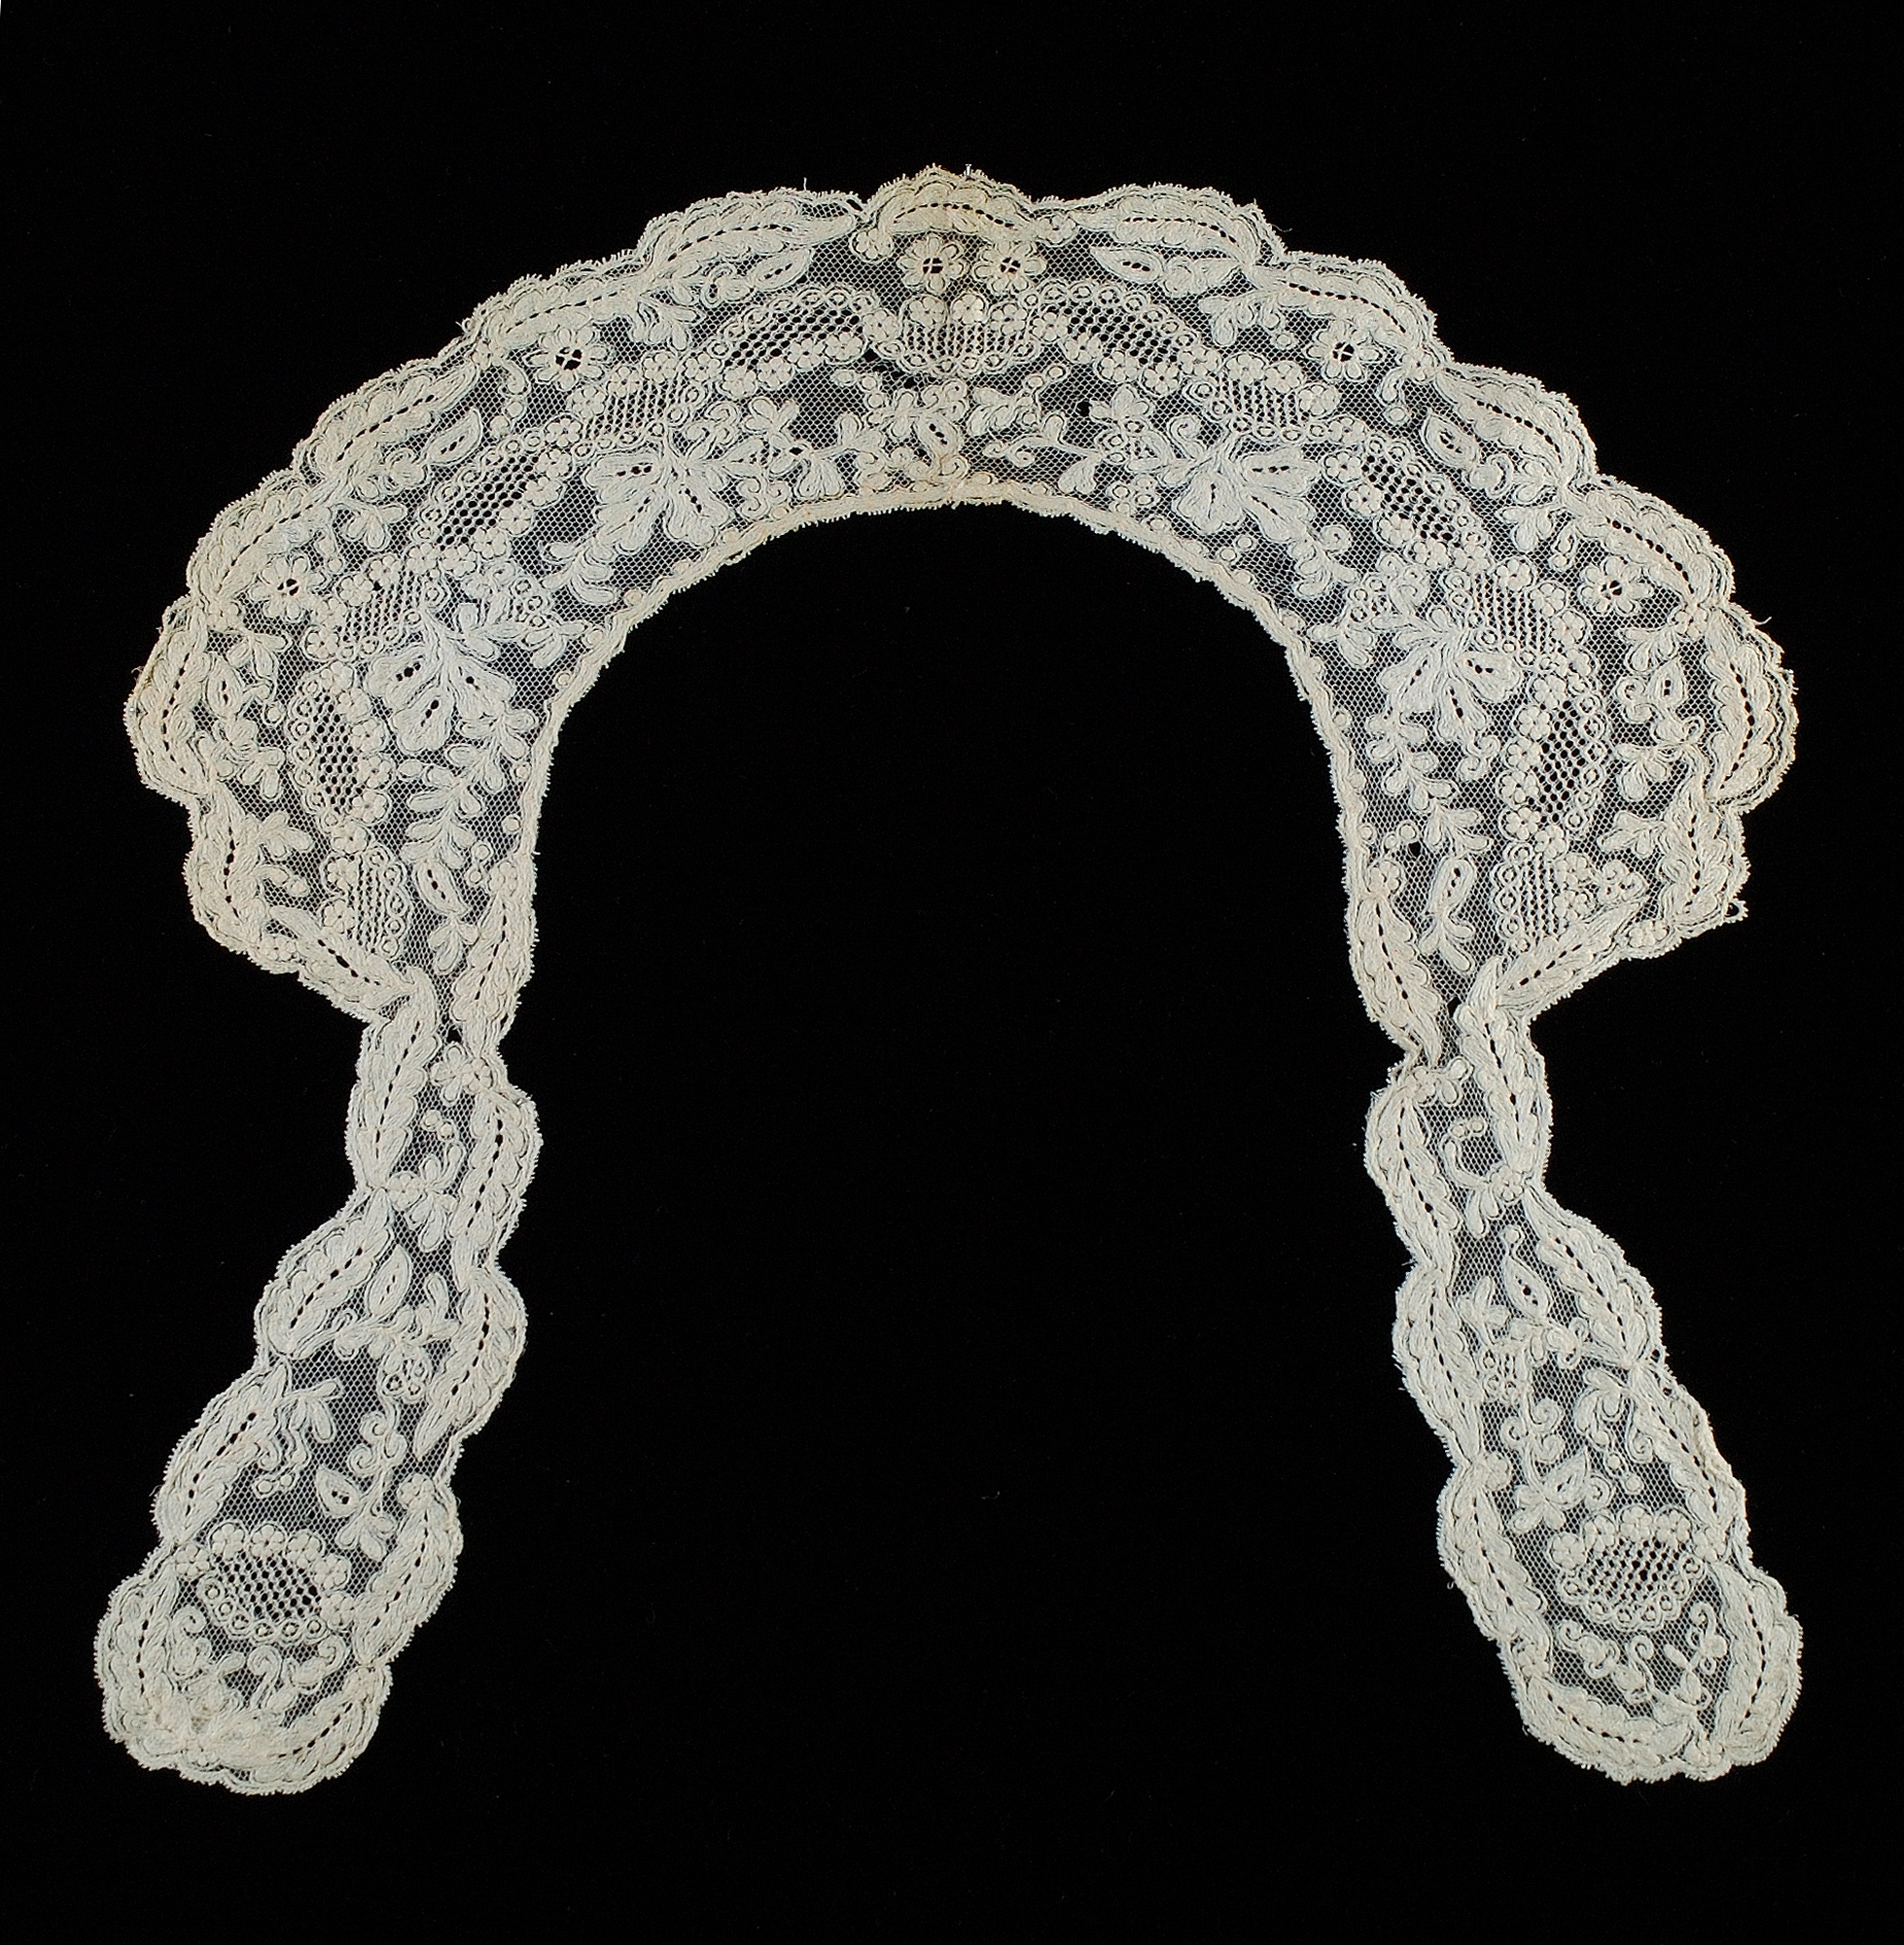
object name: collar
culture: irish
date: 1850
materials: linen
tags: flowers